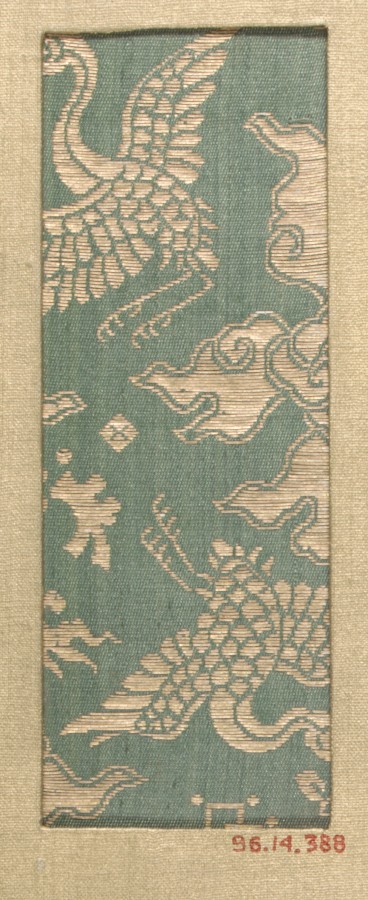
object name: piece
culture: japanese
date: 1701-1900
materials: silk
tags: cranes